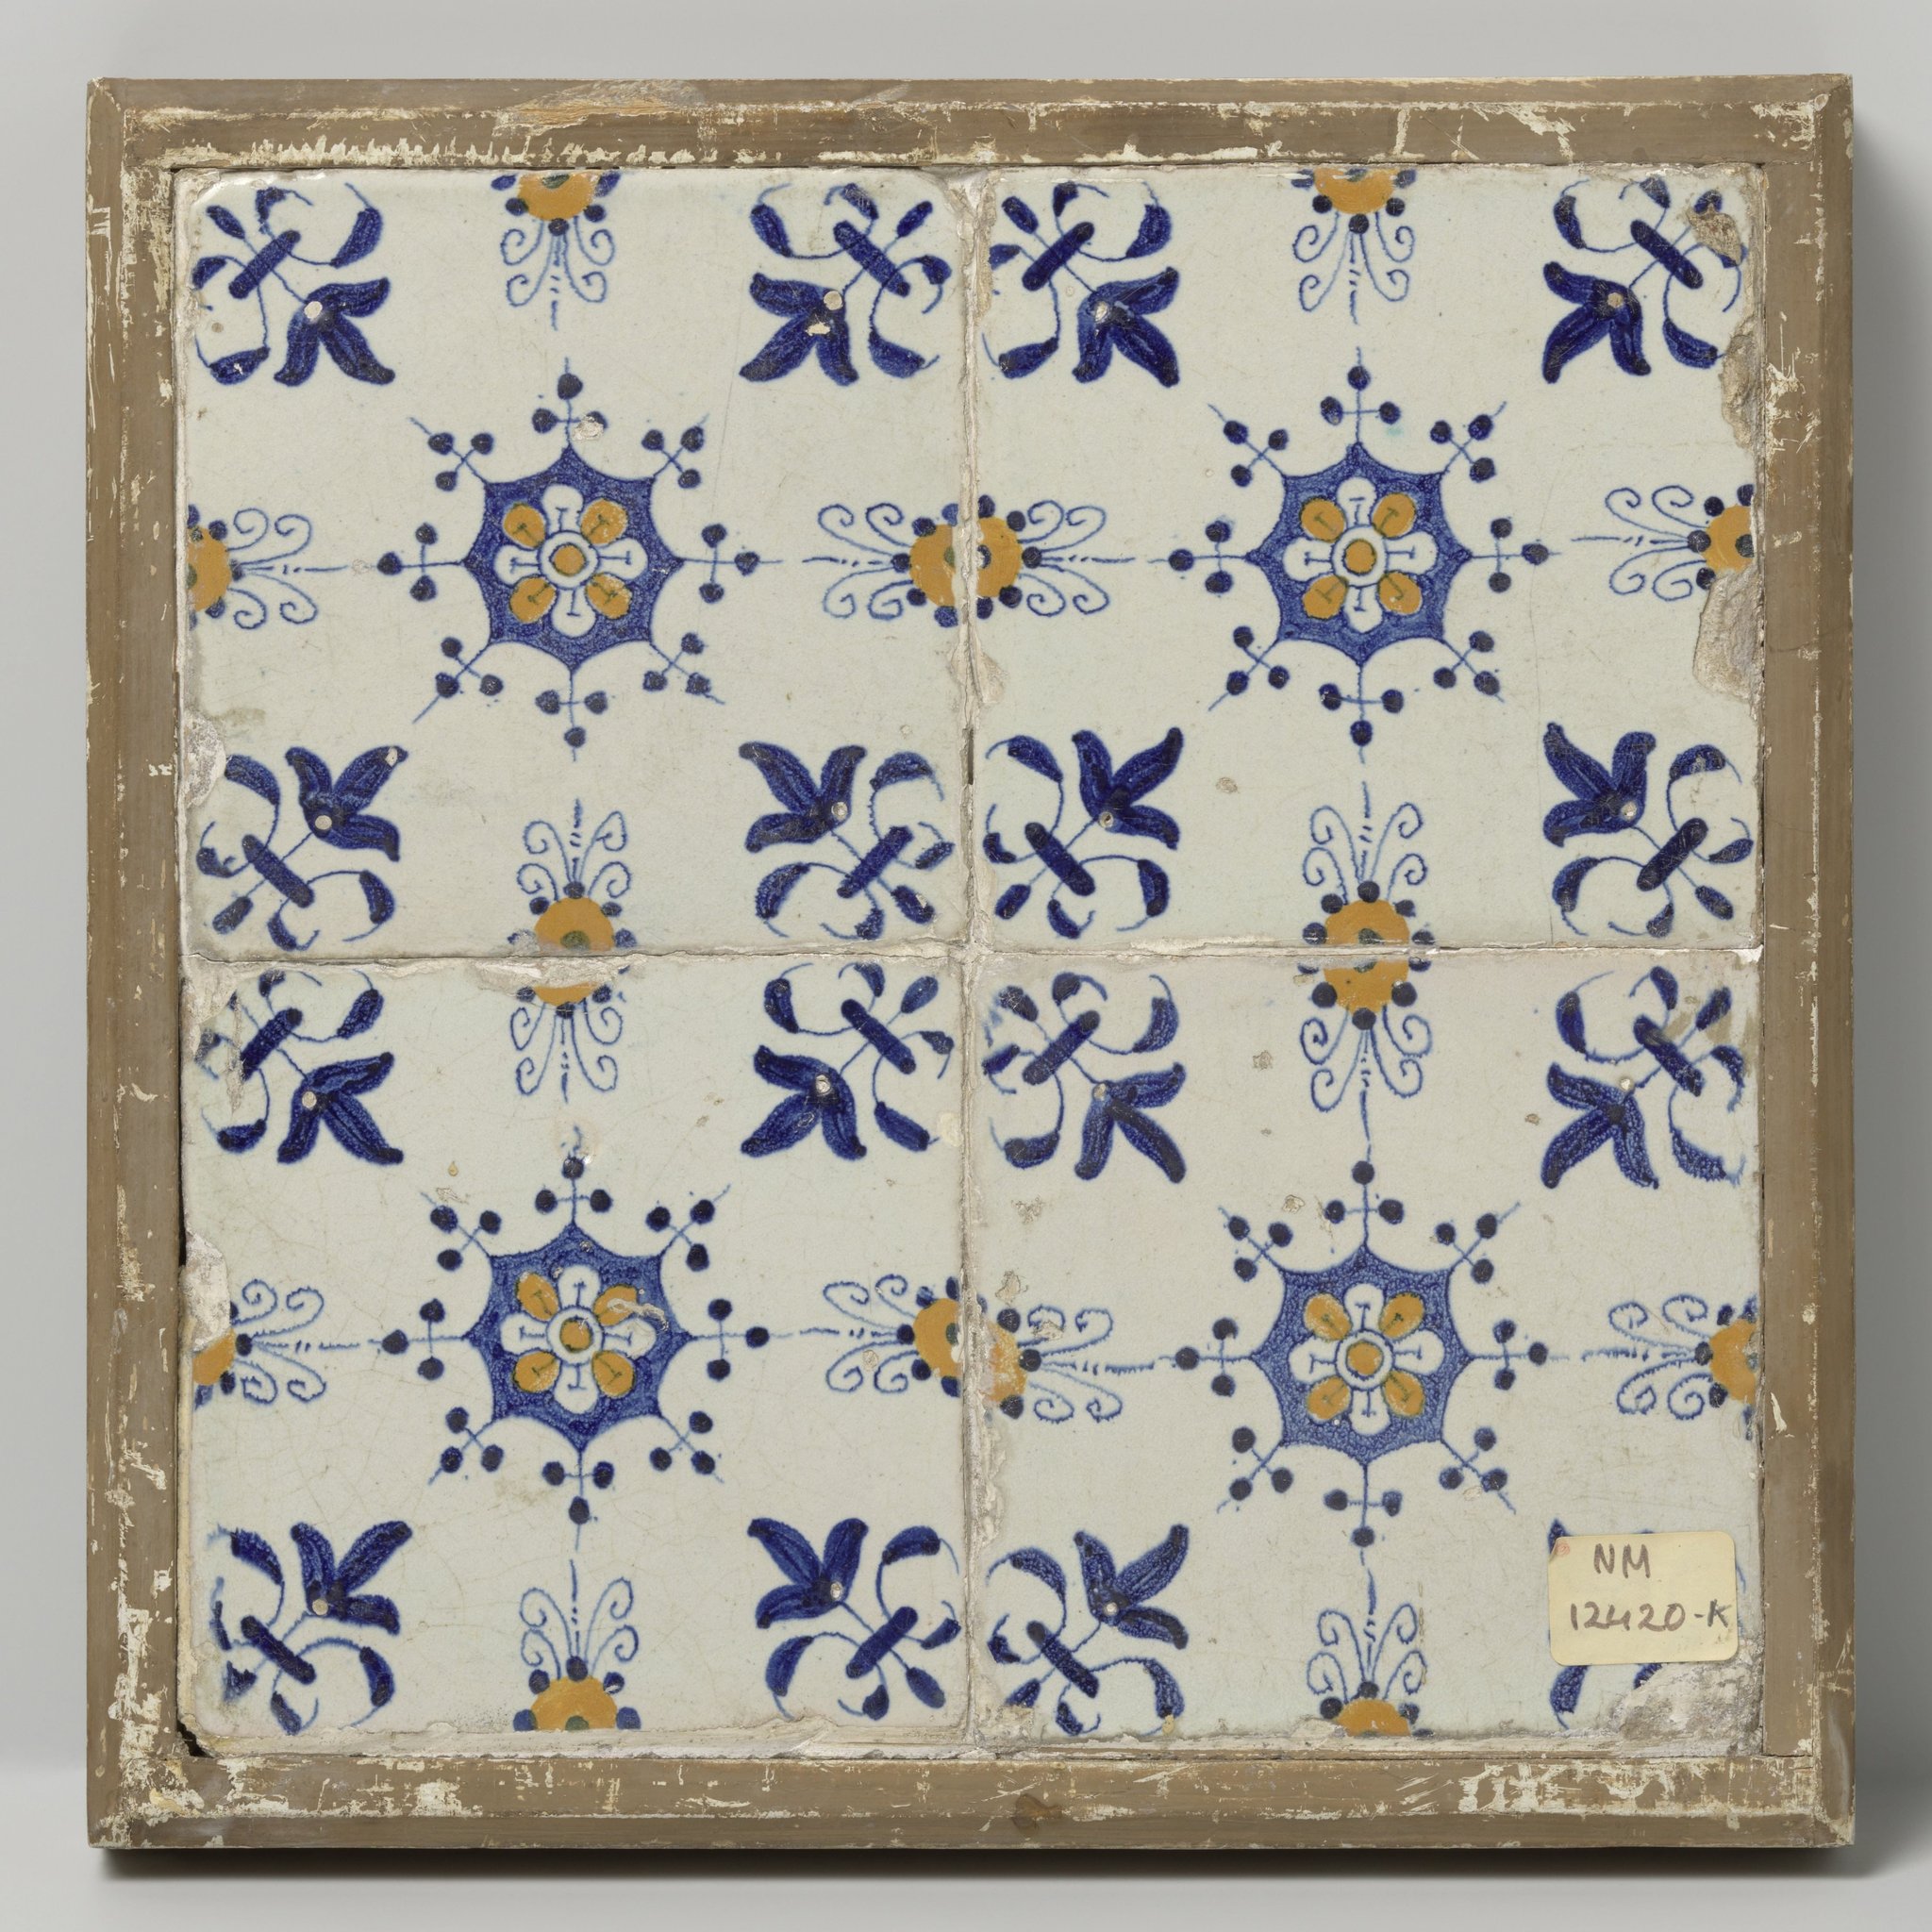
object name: tile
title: Veld van vier tegels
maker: Anonymous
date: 1640-1660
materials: earthenware, glaze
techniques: maiolica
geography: haarlem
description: Veld van 4 tegels (2 x 2) elk met een veelkleurige (blauw en oranje) rozet omgeven door driestippen. Langs de randen een halve rozet met veertoef. In de hoeken, een lelie.